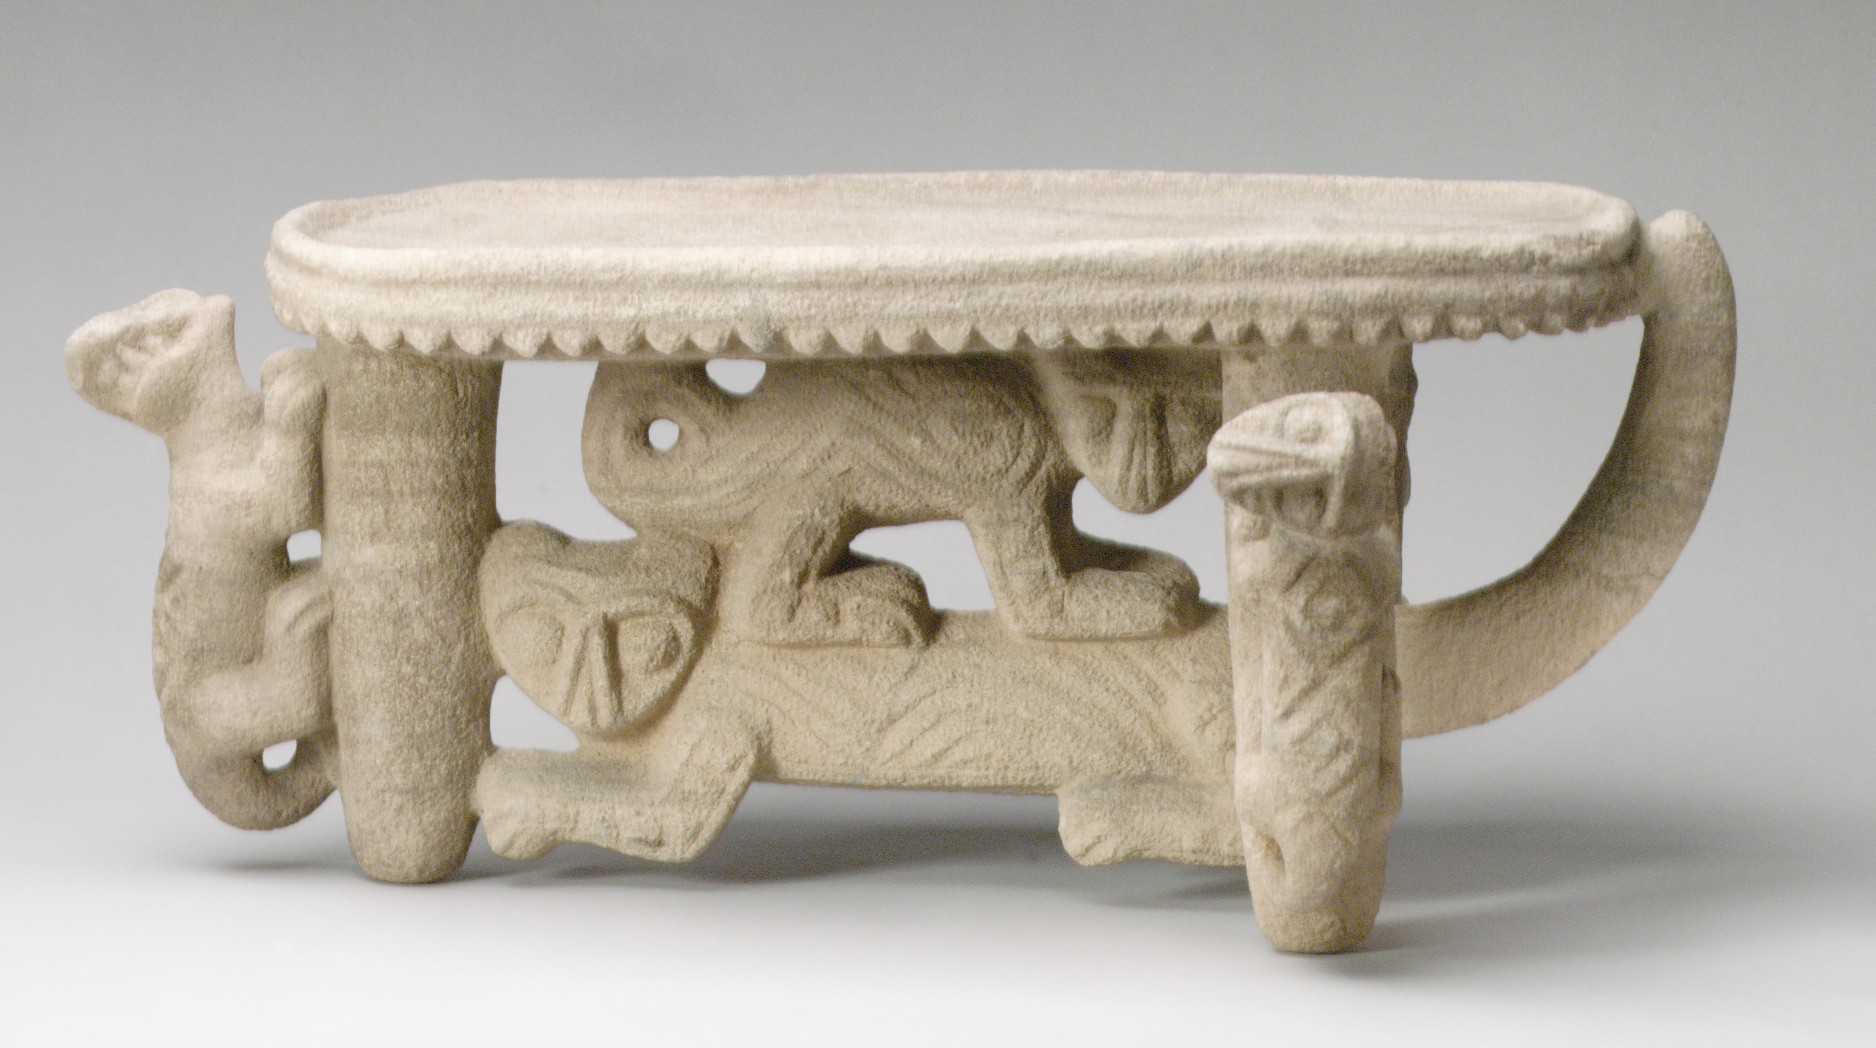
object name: metate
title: Flying Panel Metate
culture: atlantic watershed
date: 1-500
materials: stone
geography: costa rica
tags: animals